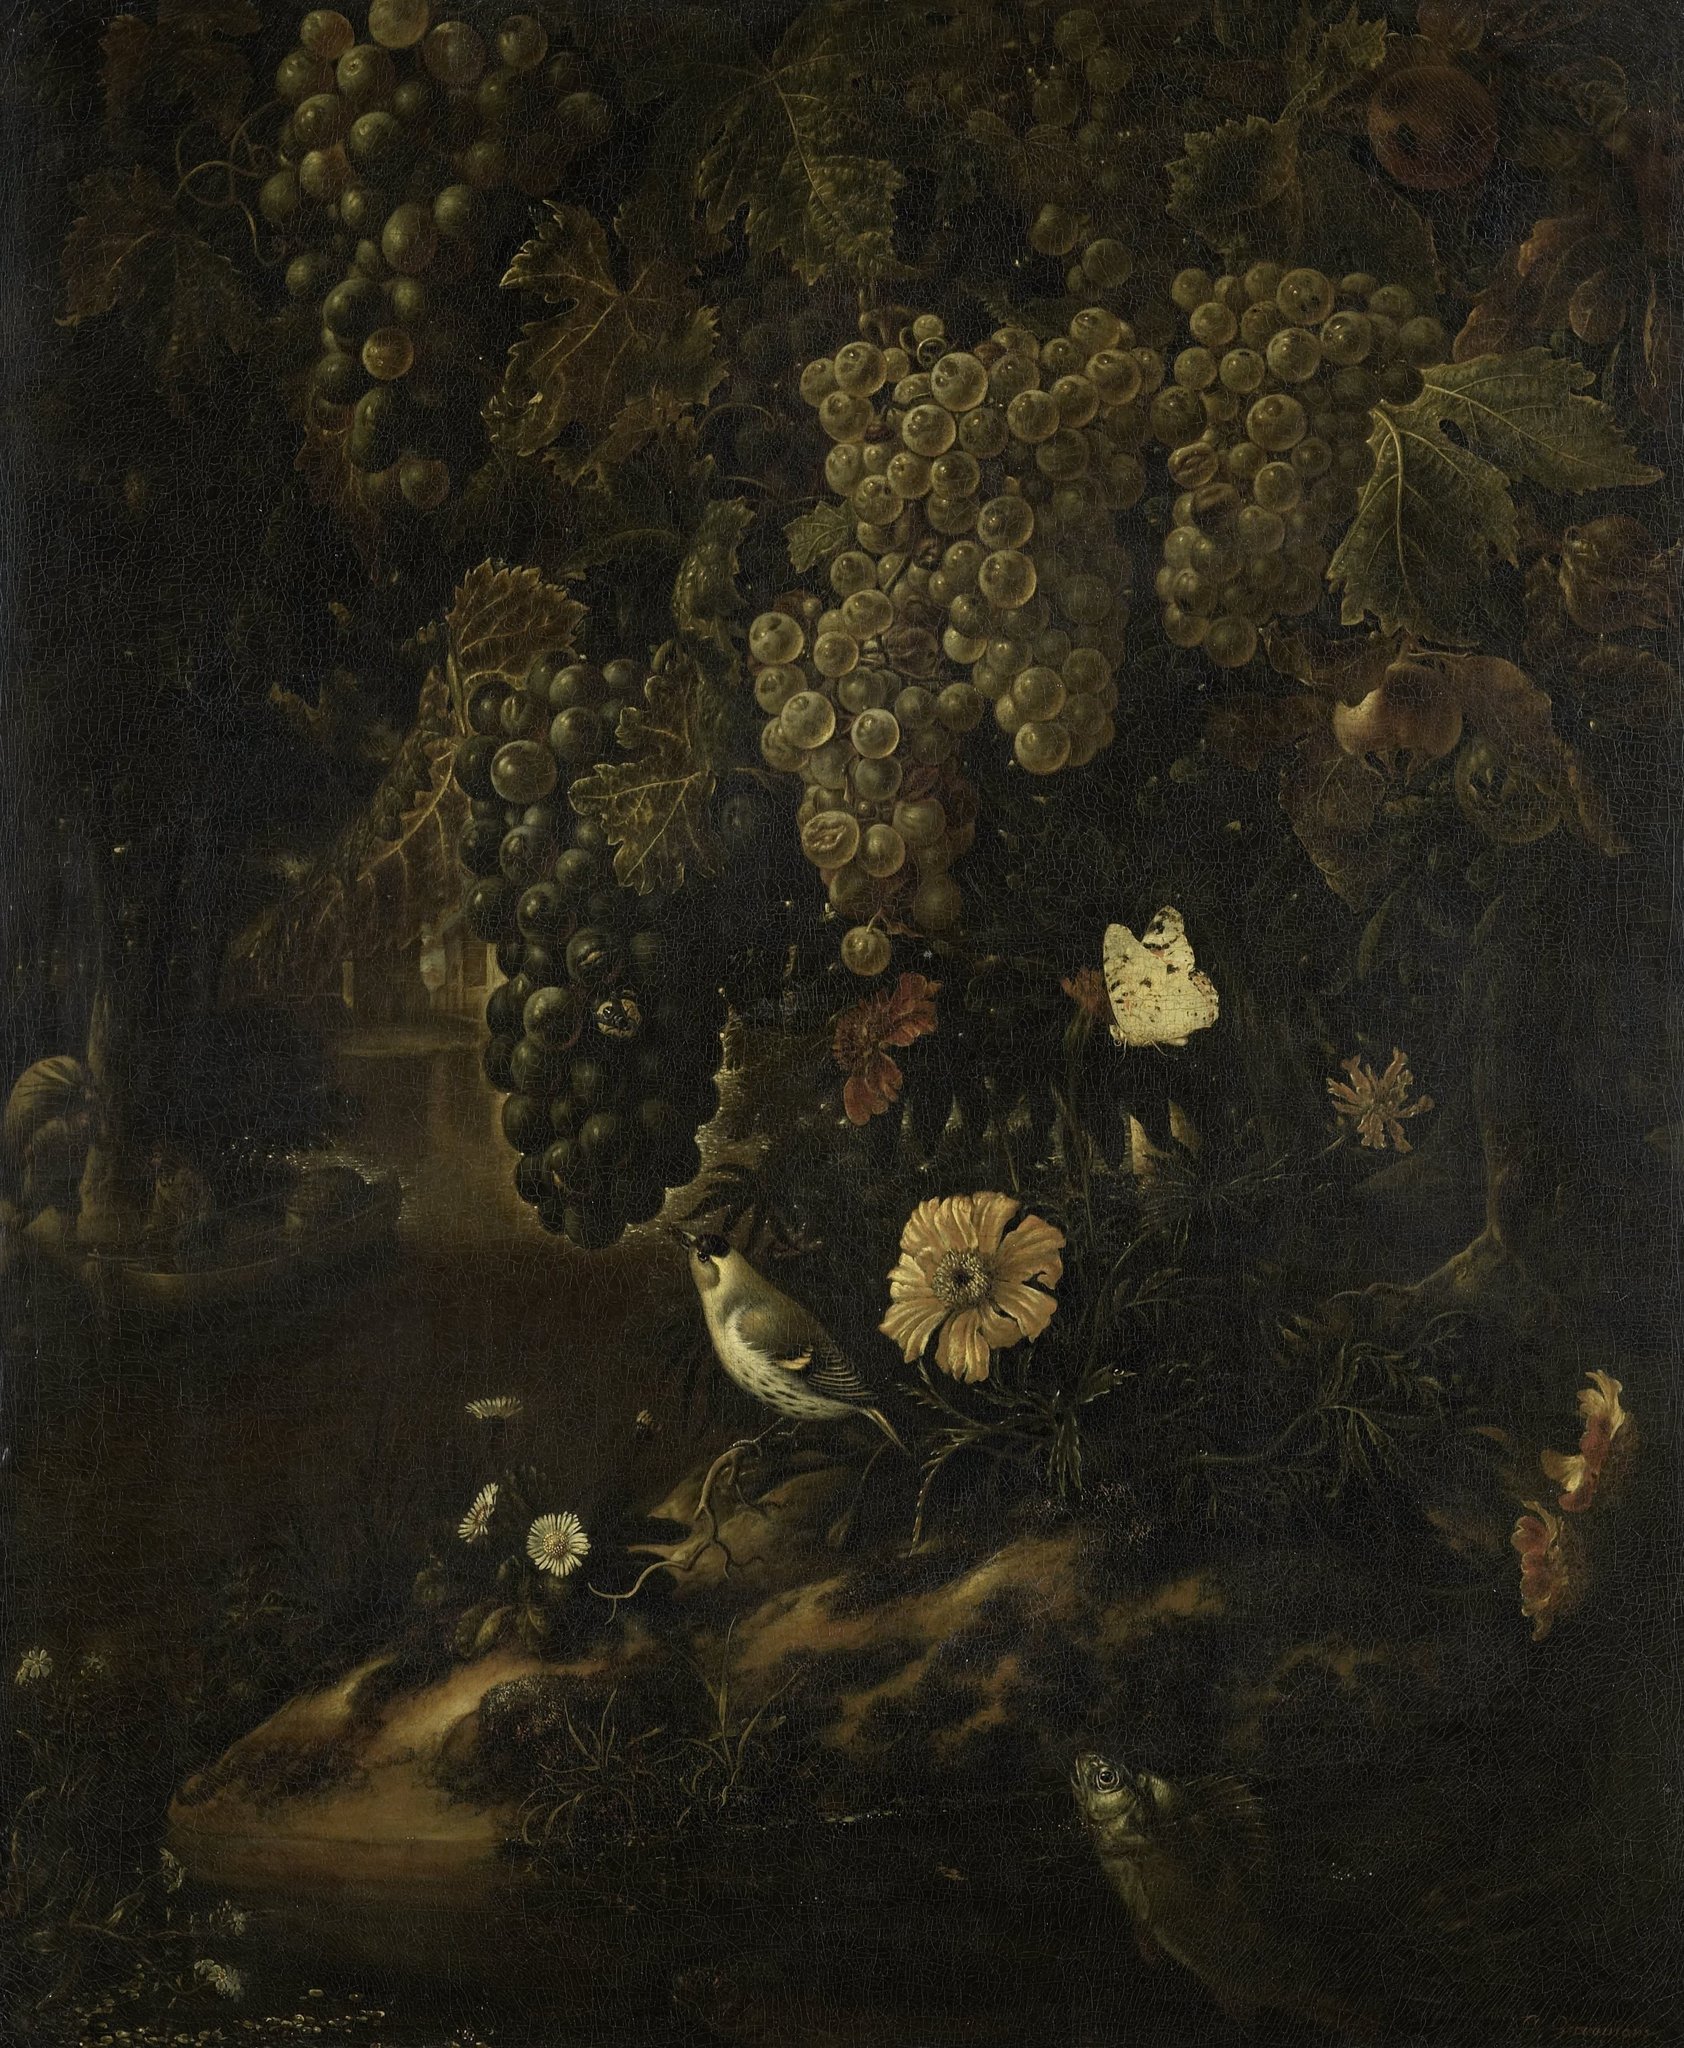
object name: painting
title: Grapes, Flowers and Animals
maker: isac vromans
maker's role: painter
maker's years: 1648-1719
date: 1665-1719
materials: canvas, oil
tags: birds, fishes, insects: butterfly, insects, bunch of grapes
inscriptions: signature: ‘I. Vroomans’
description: Wijnranken met zware druiventrossen en enkele andere soorten fruit hangen laag bij de grond aan de oever van een water. Vogels pikken aan de druiven, een vis steekt zijn kop uit het water. Op de achtergrond laden twee mannen een bootje.